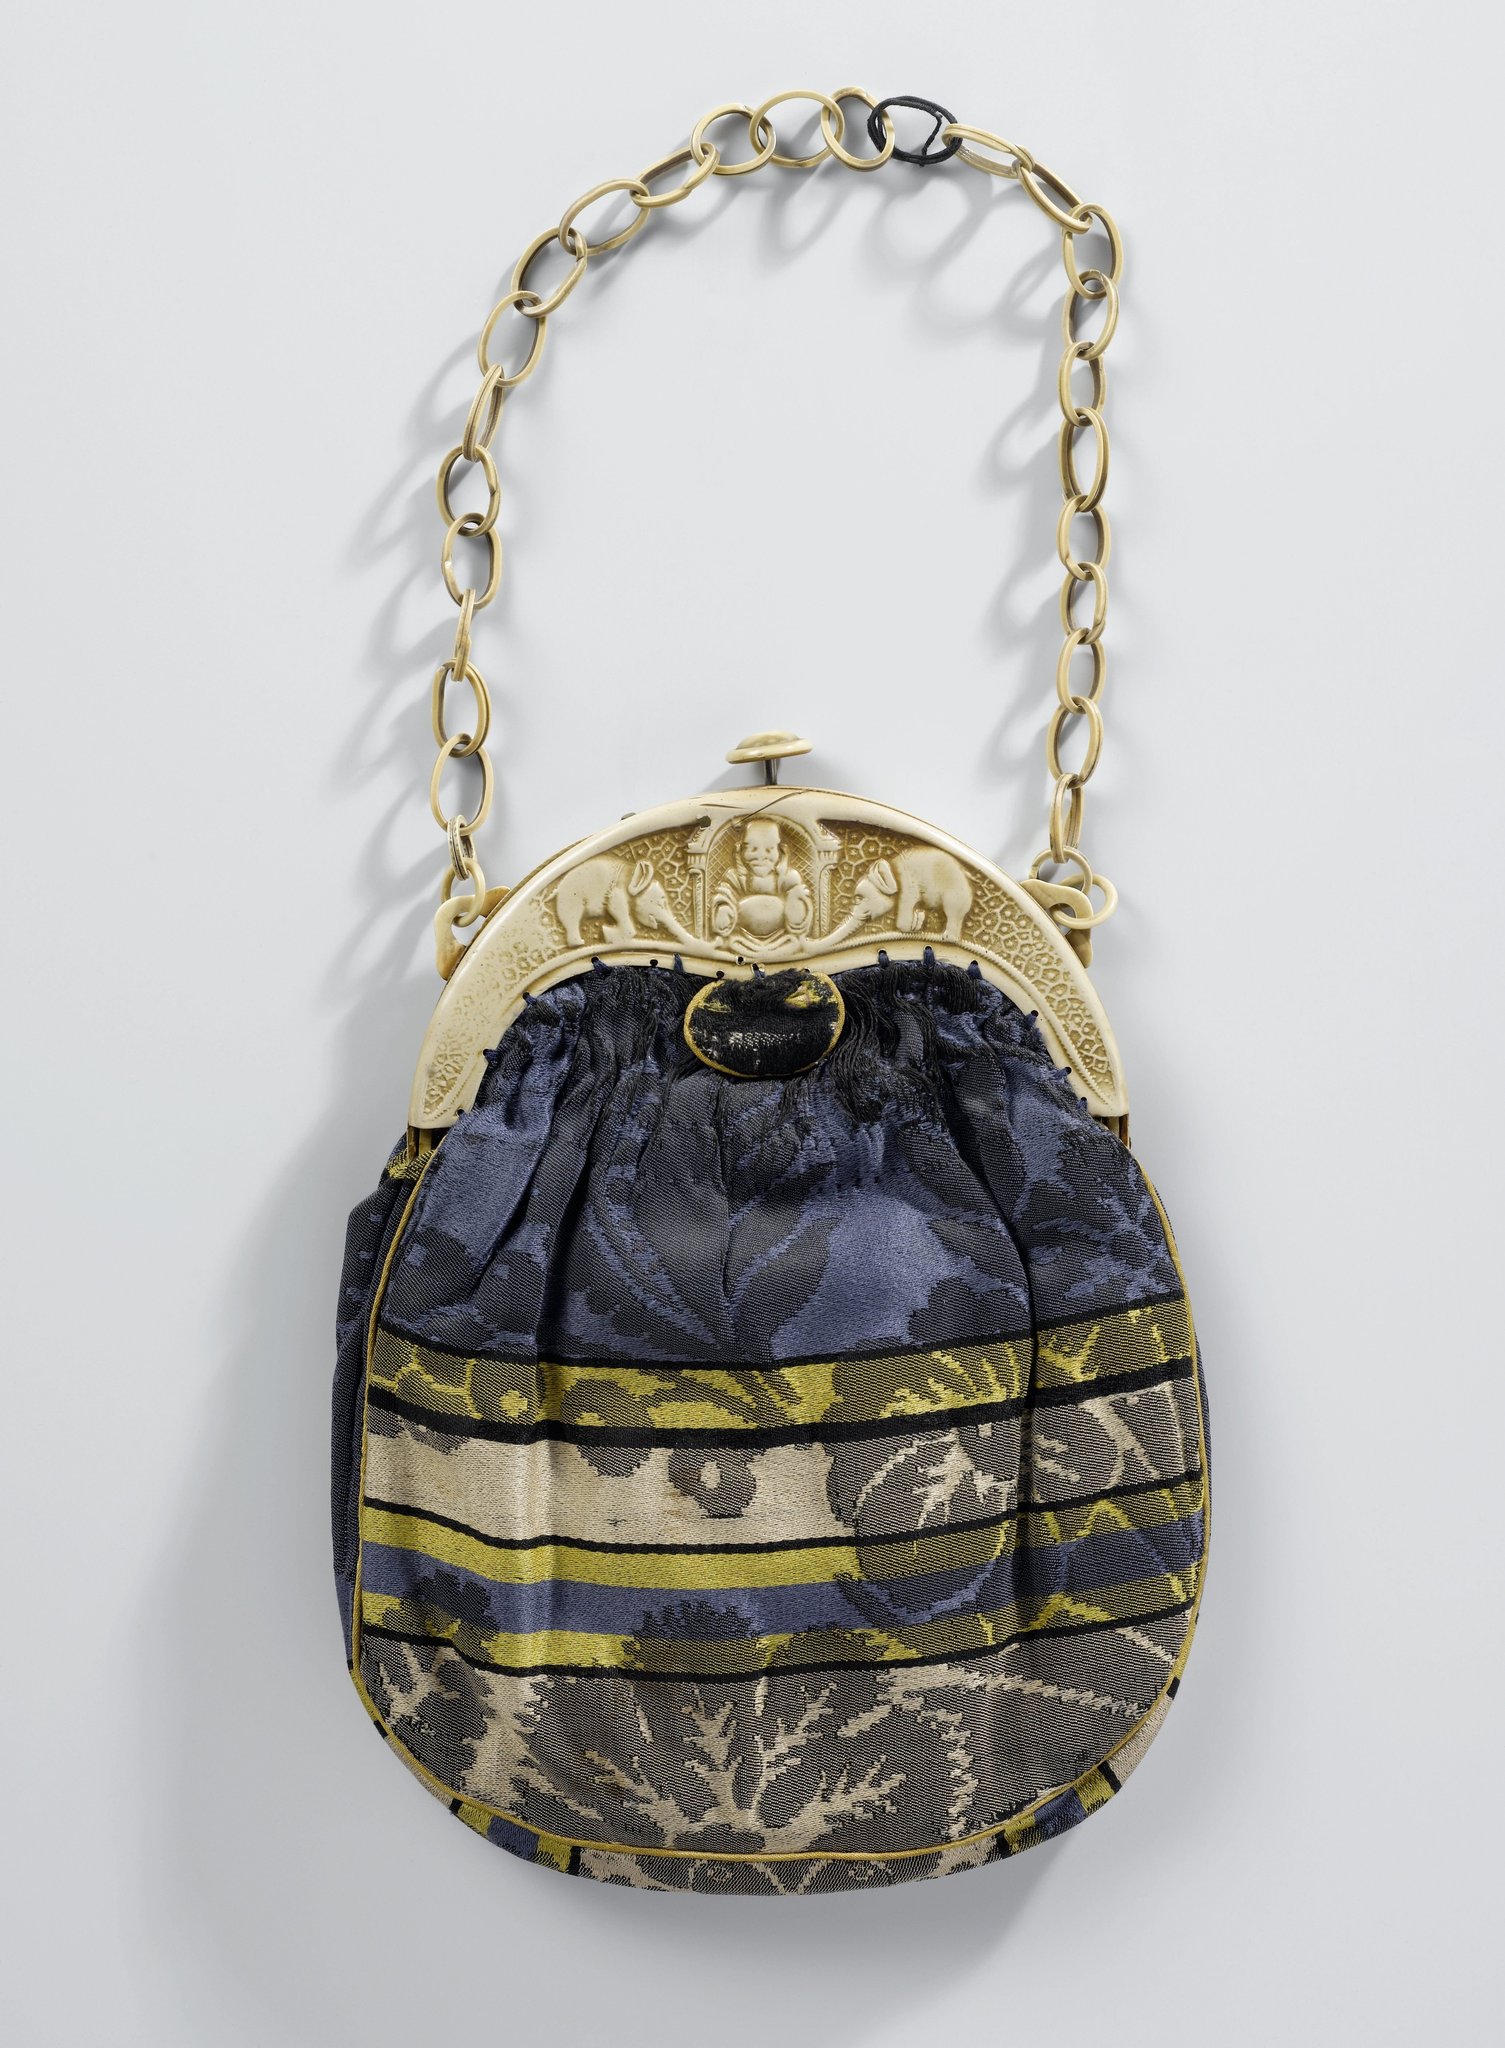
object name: beugeltas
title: Beugeltas met afgeronde beugel van ivoorkleurige celluloid waarop in reliëf een Boeddha tussen twee olifanten, en een buidel van blauw, groen, zwart en beige gebloemde en gestreepte satijn, schakelketting van ivoorkleurig celluloid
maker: Anonymous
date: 1920-1930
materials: celluloid, silk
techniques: casting, weave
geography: western europe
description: Beugeltas in een afgeronde vorm, van blauw, groen, zwart en beige satijn met aan beide kanten grote ingeweven bloemen en horizontale strepen. Tussen de voor- en achterkant van de tas een smalle baan van dezelfde stof, met langs de naden een gele boord. De ivoorkleurige boogvormige beugel is van celluloid, waarop aan beide kanten in reliëf een boeddha temidden van twee olifanten die door hun voorpoten knielen. Bovenop de beugel een knipsluiting en twee ogen, waaraan als hengsel een schakelketting van hetzelfde materiaal als de beugel. Voering van gele changeant zijde.